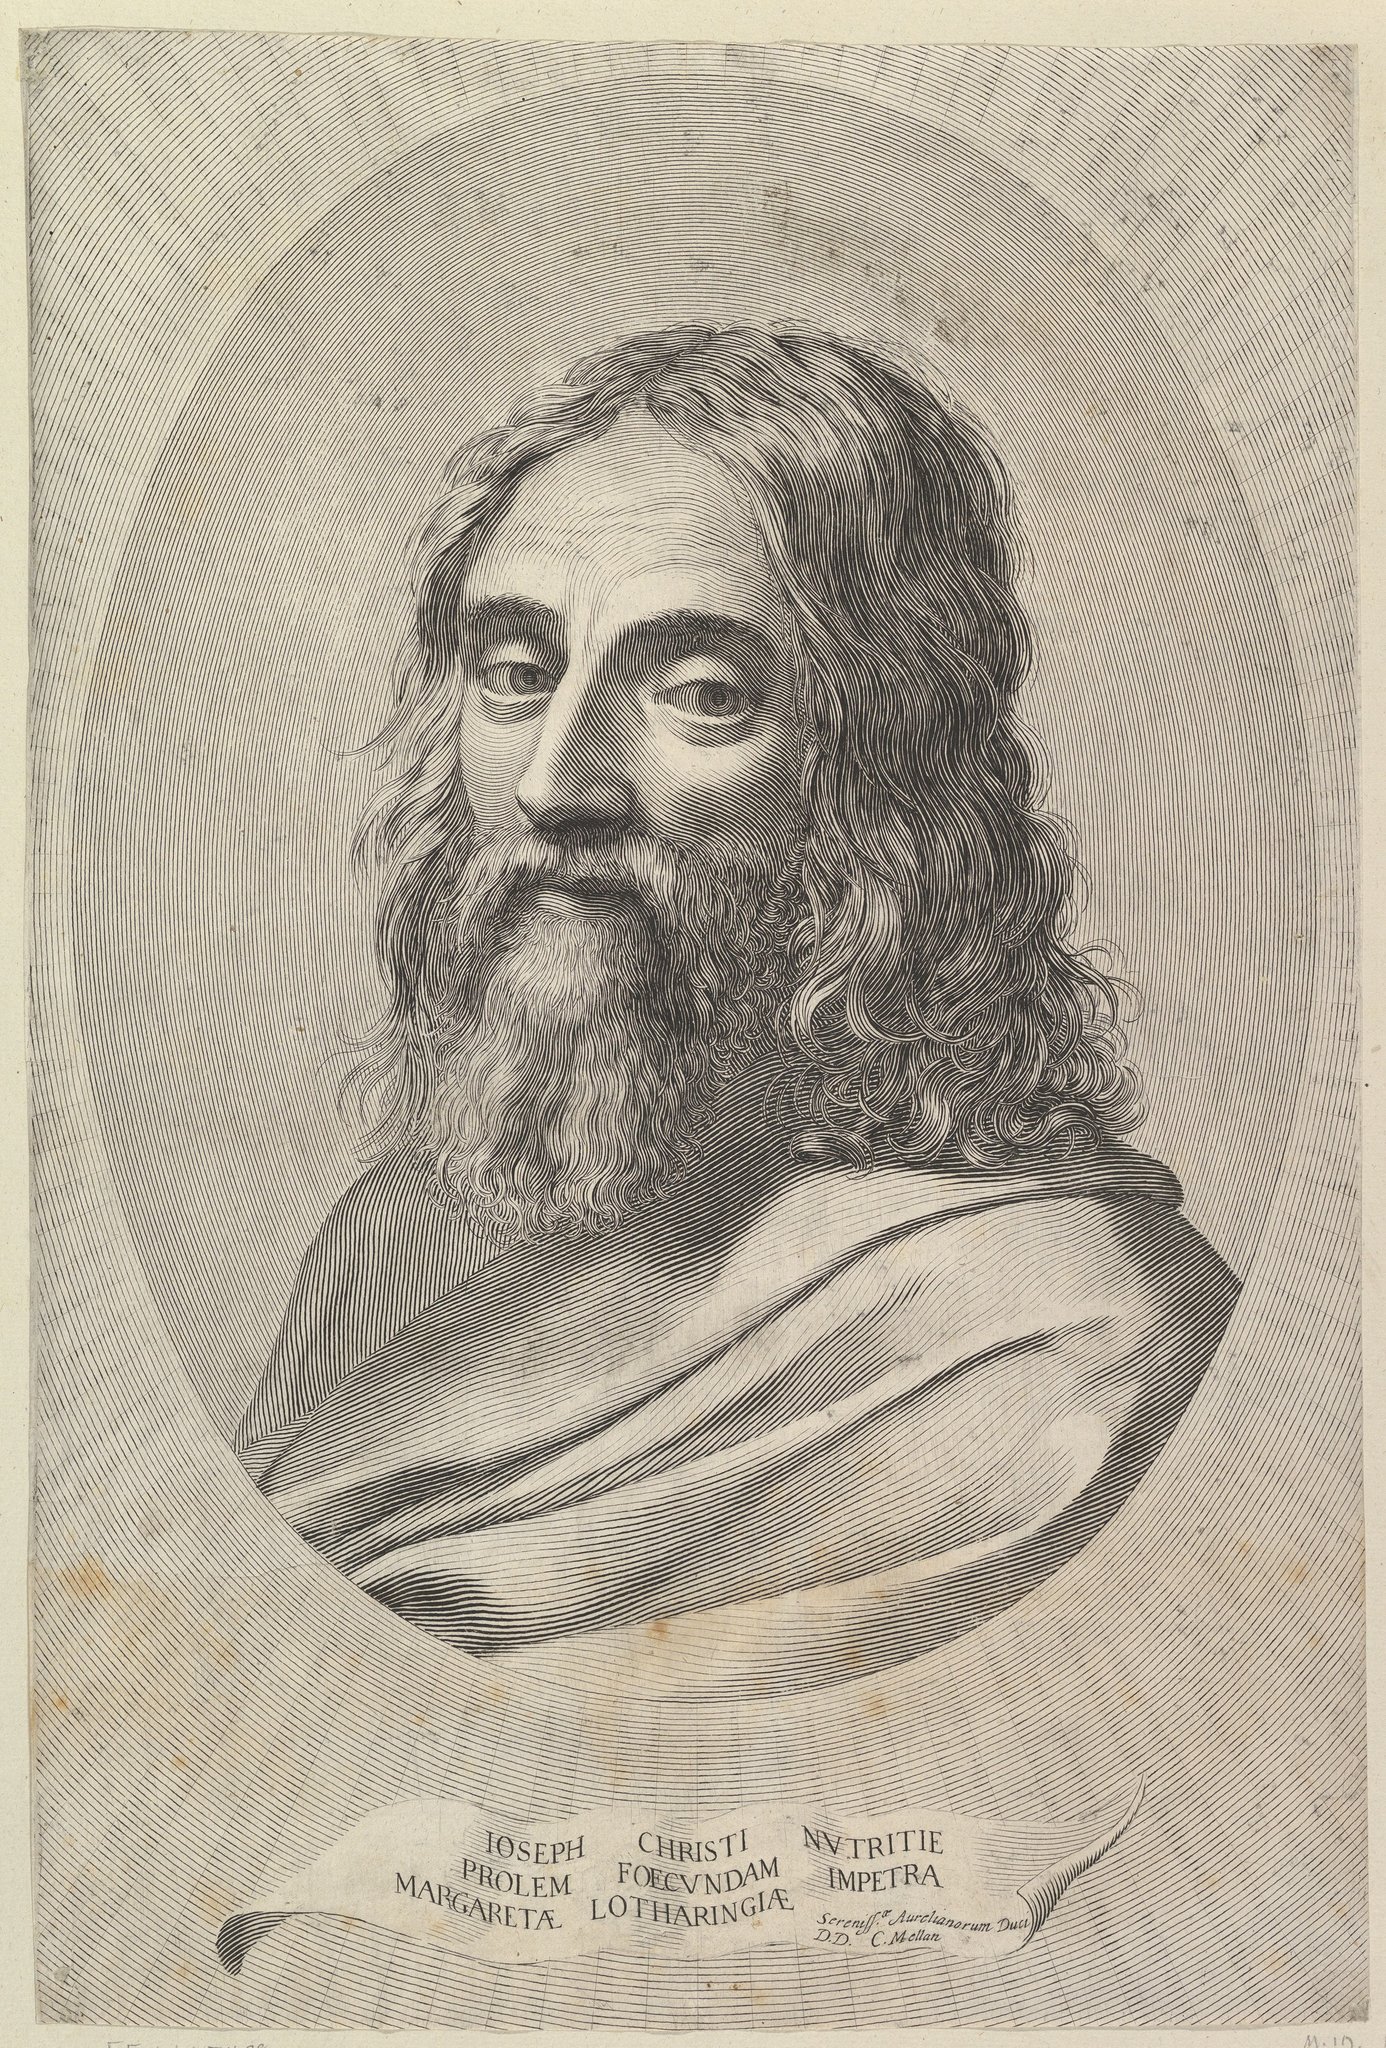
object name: print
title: Bust of St. Joseph in an Oval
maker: claude mellan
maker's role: artist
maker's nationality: french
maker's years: 1598-1688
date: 1600-1688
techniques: engraving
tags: portraits,saints